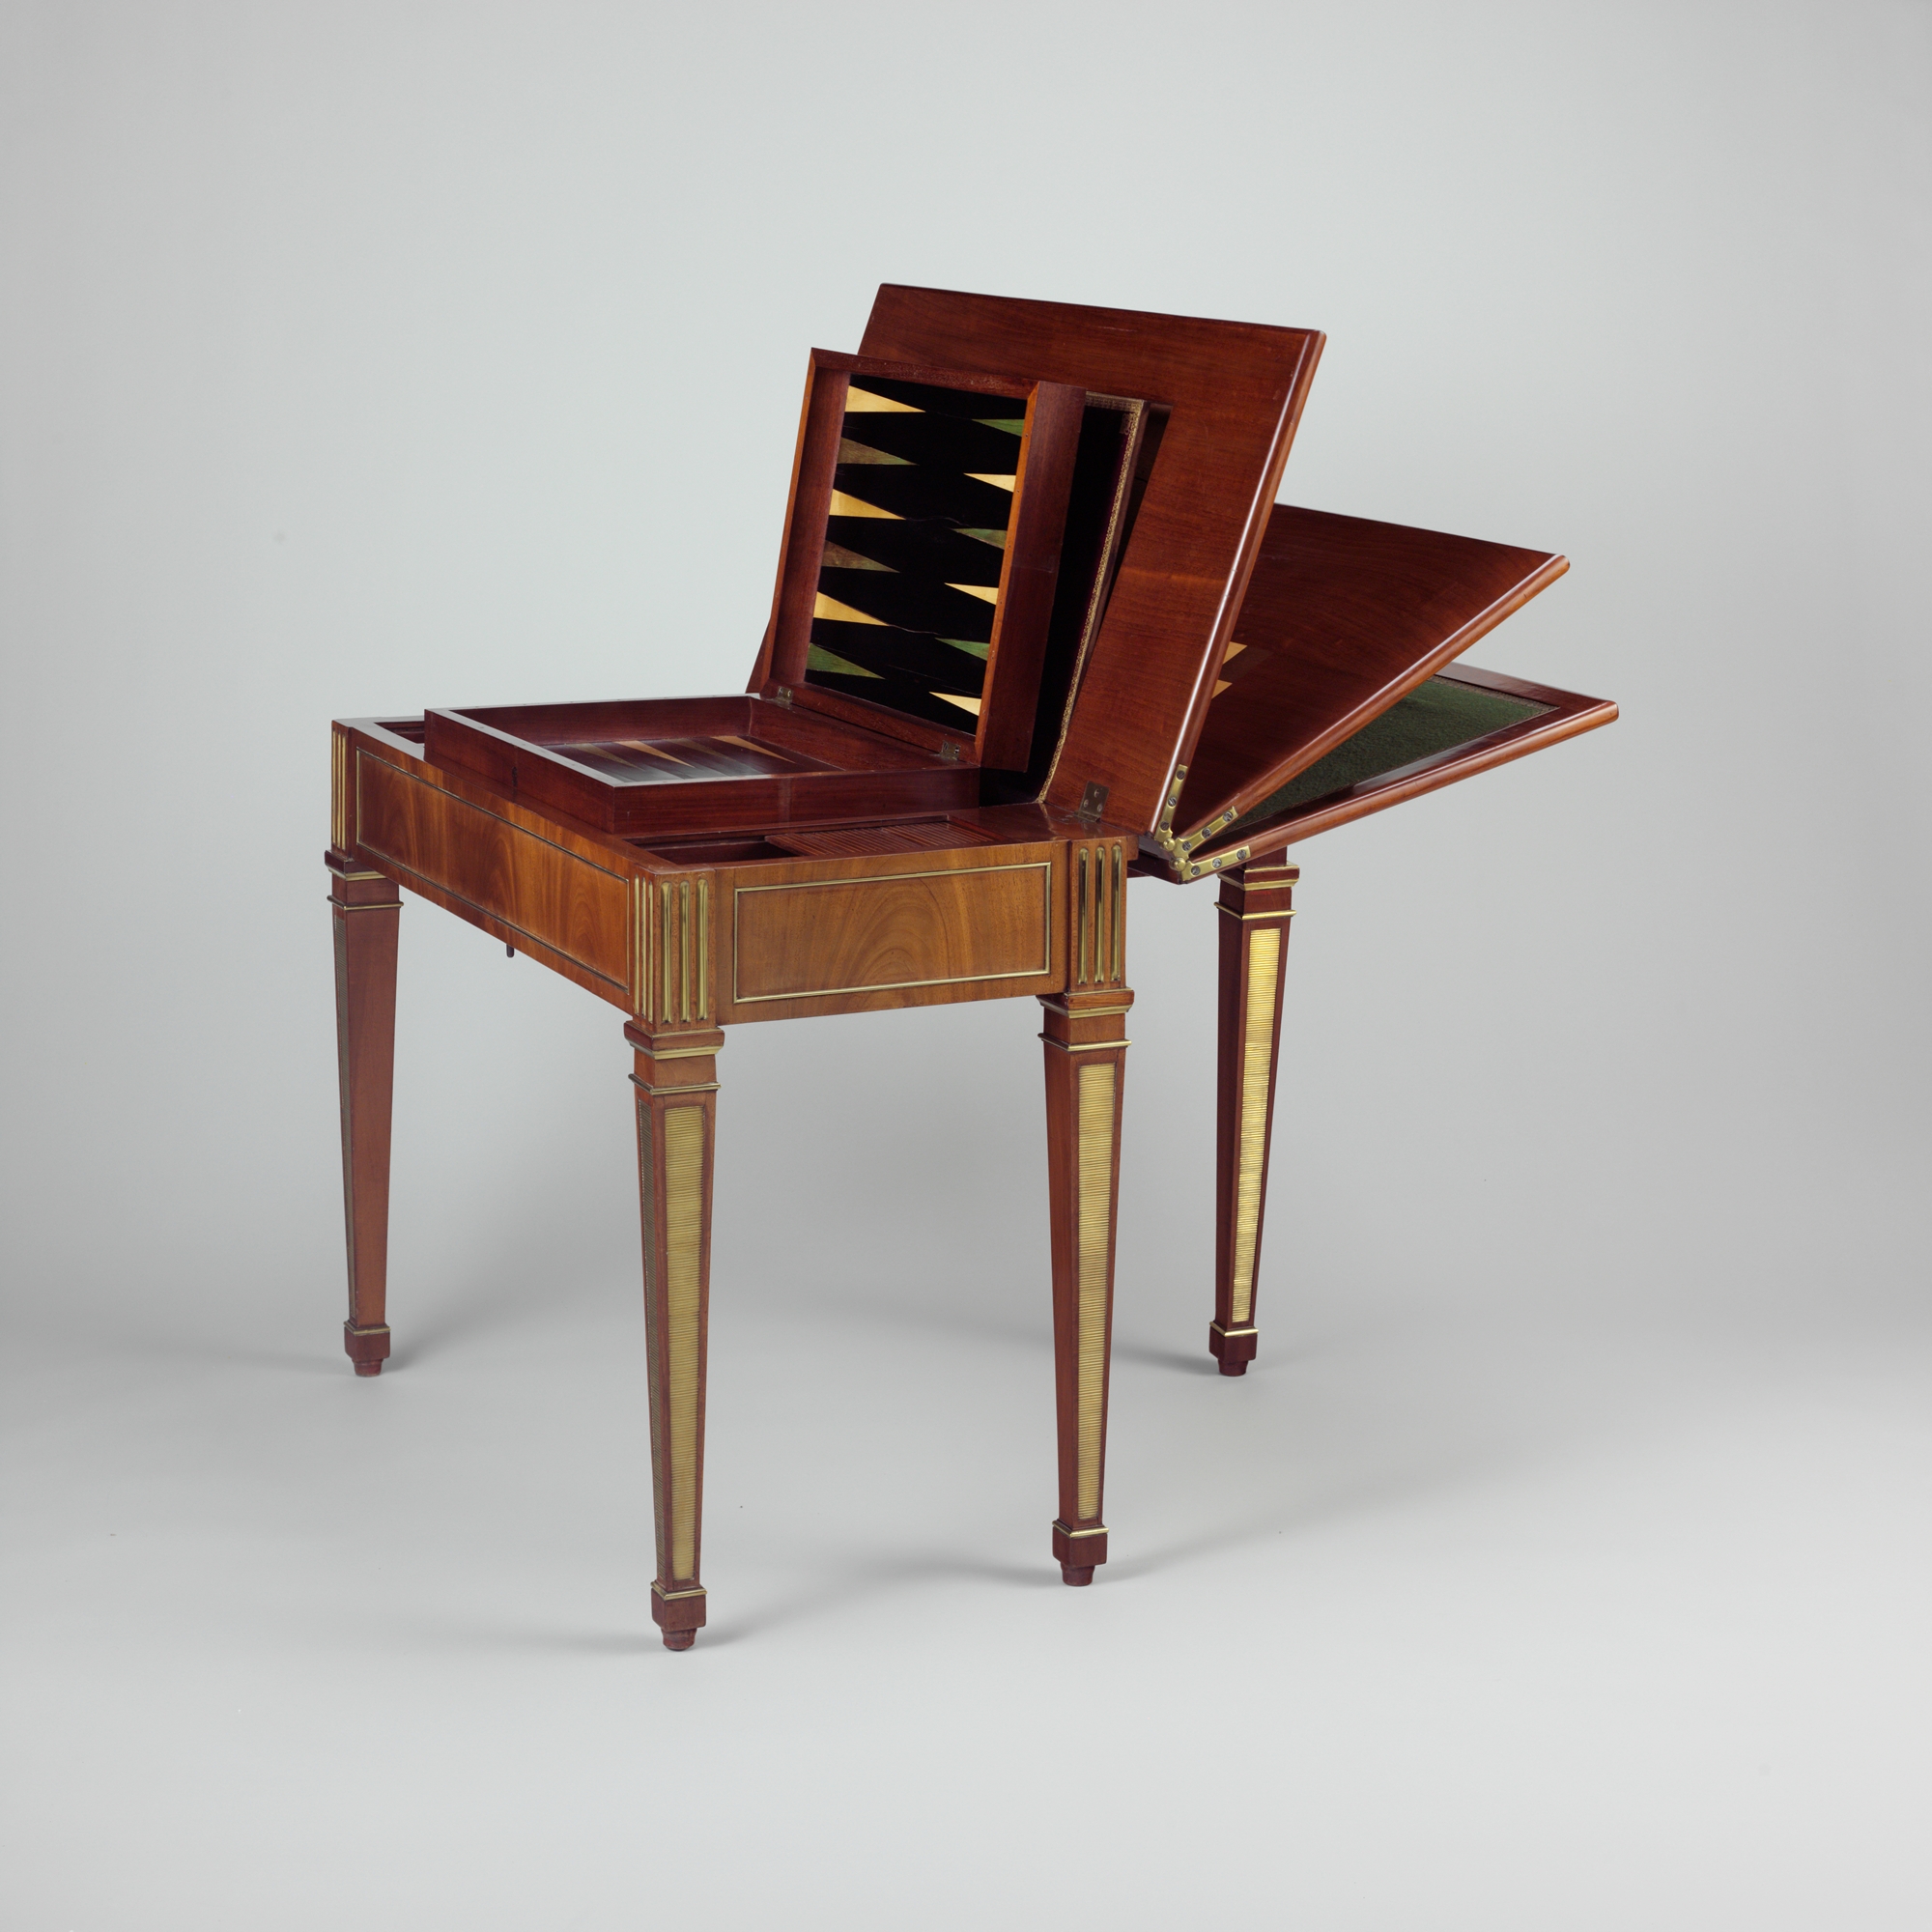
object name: game table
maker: david roentgen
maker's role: maker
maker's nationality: german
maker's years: 1743-1807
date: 1780-1783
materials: brass, felt, gilt bronze, iron, leather, wood, steel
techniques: gilding, stain, tooling, veneering